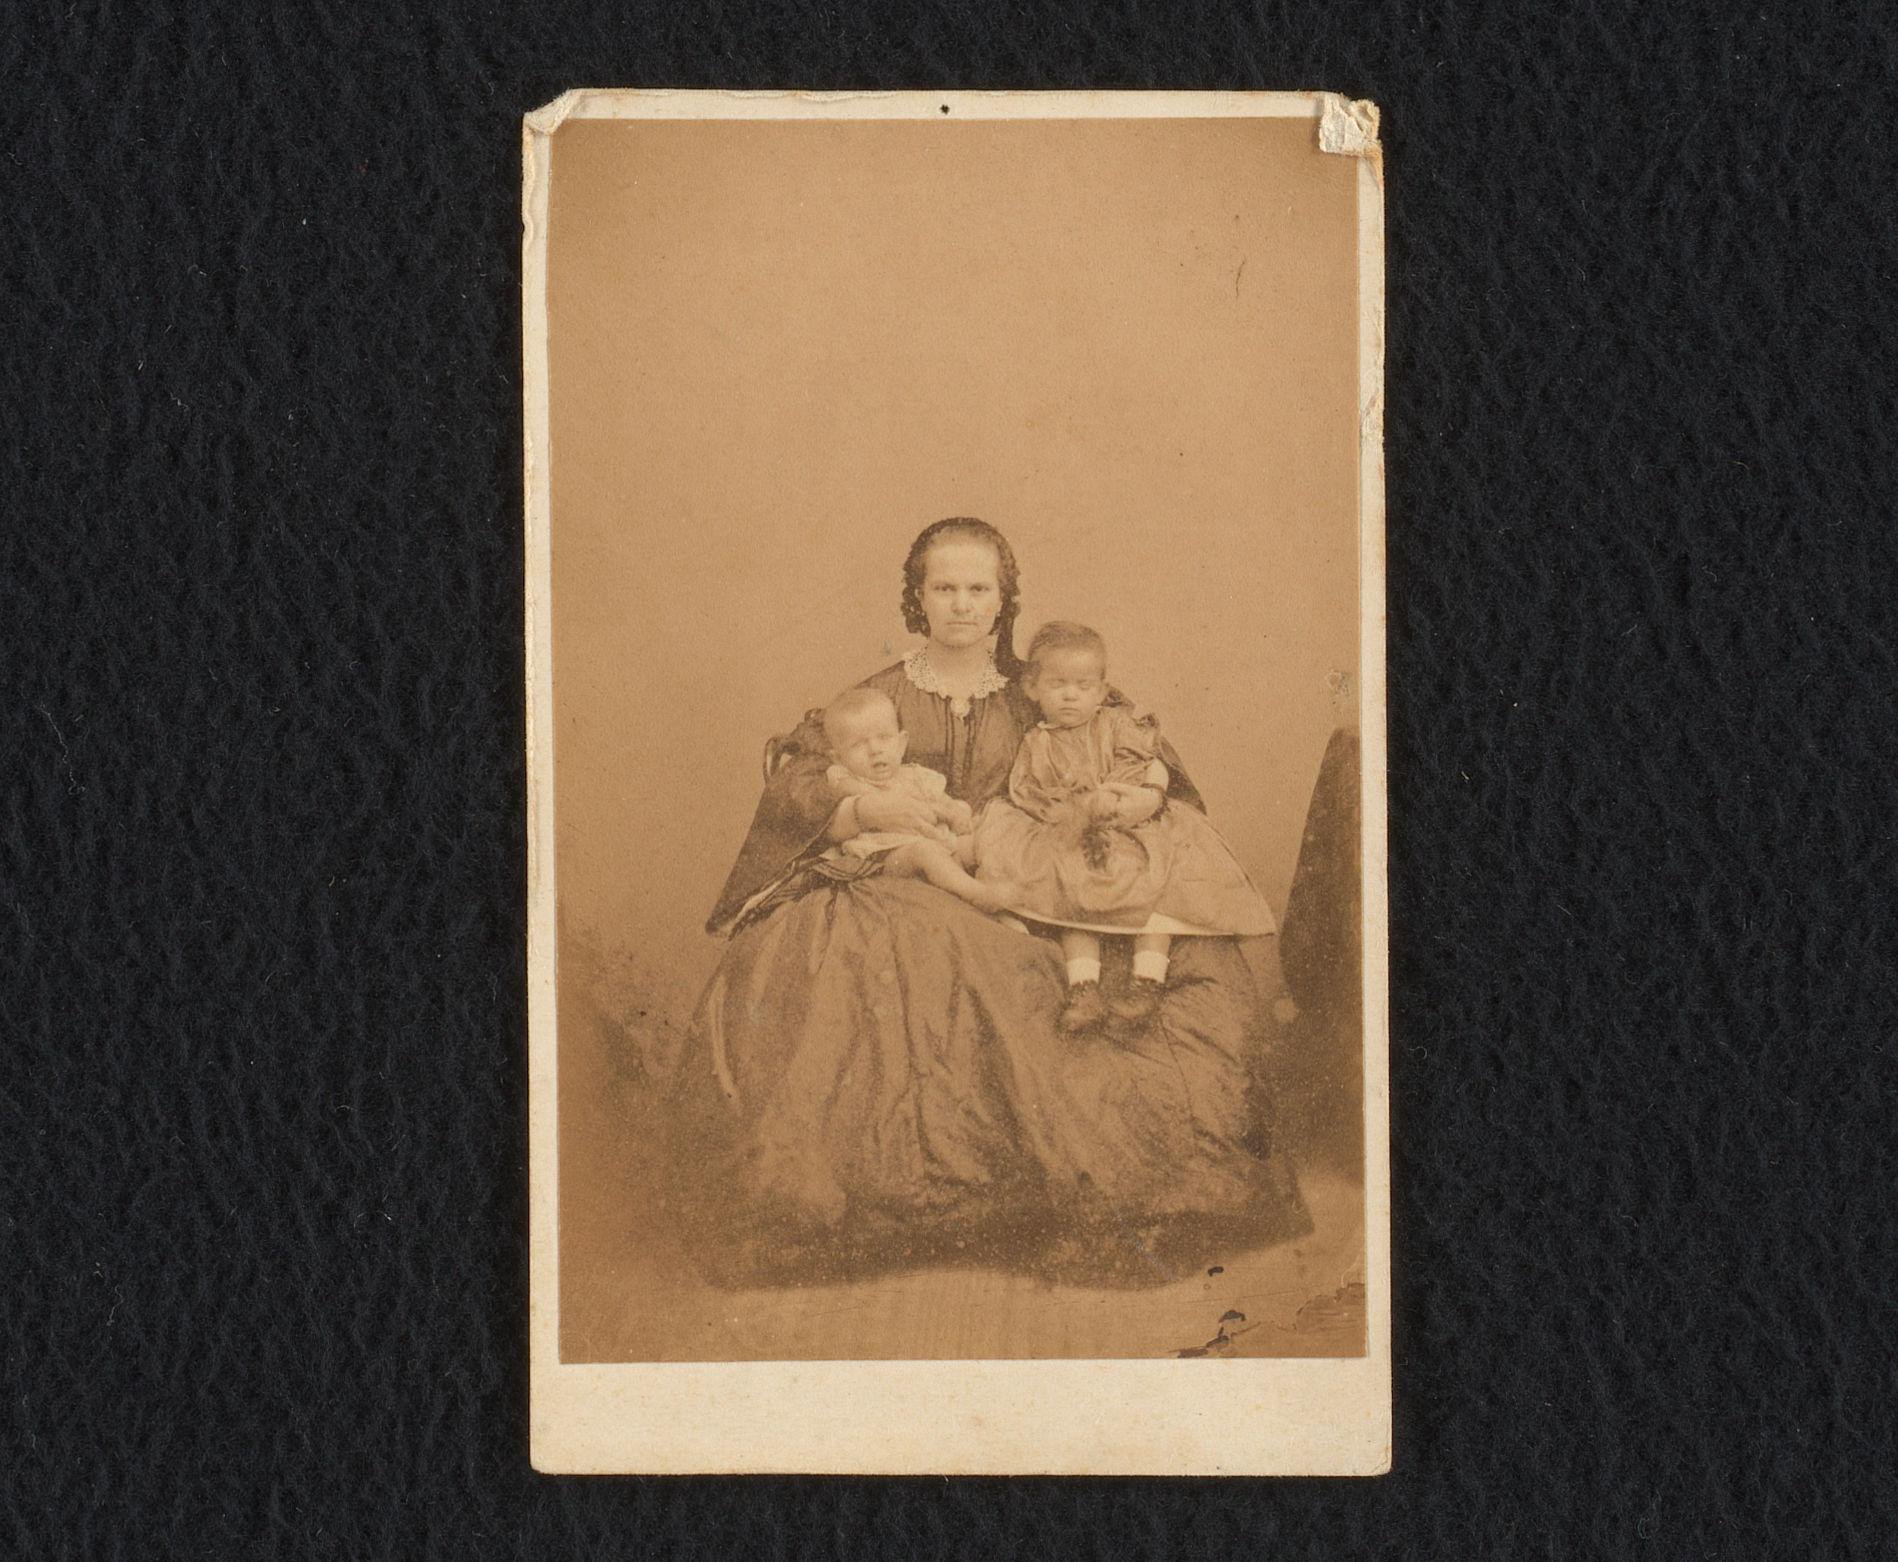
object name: carte de visite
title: Portret van Jacoba de Lange-Wiggers van Kerchem met twee van haar kinderen, mogelijk Margo en Jacob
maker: Anonymous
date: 1860-1862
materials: cardboard, paper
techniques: albumen print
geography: batavia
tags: margaretha jacoba johanna kessler-de lange (margo), historical persons - bb - woman, mother and child(ren), woman and child(ren) (family group)